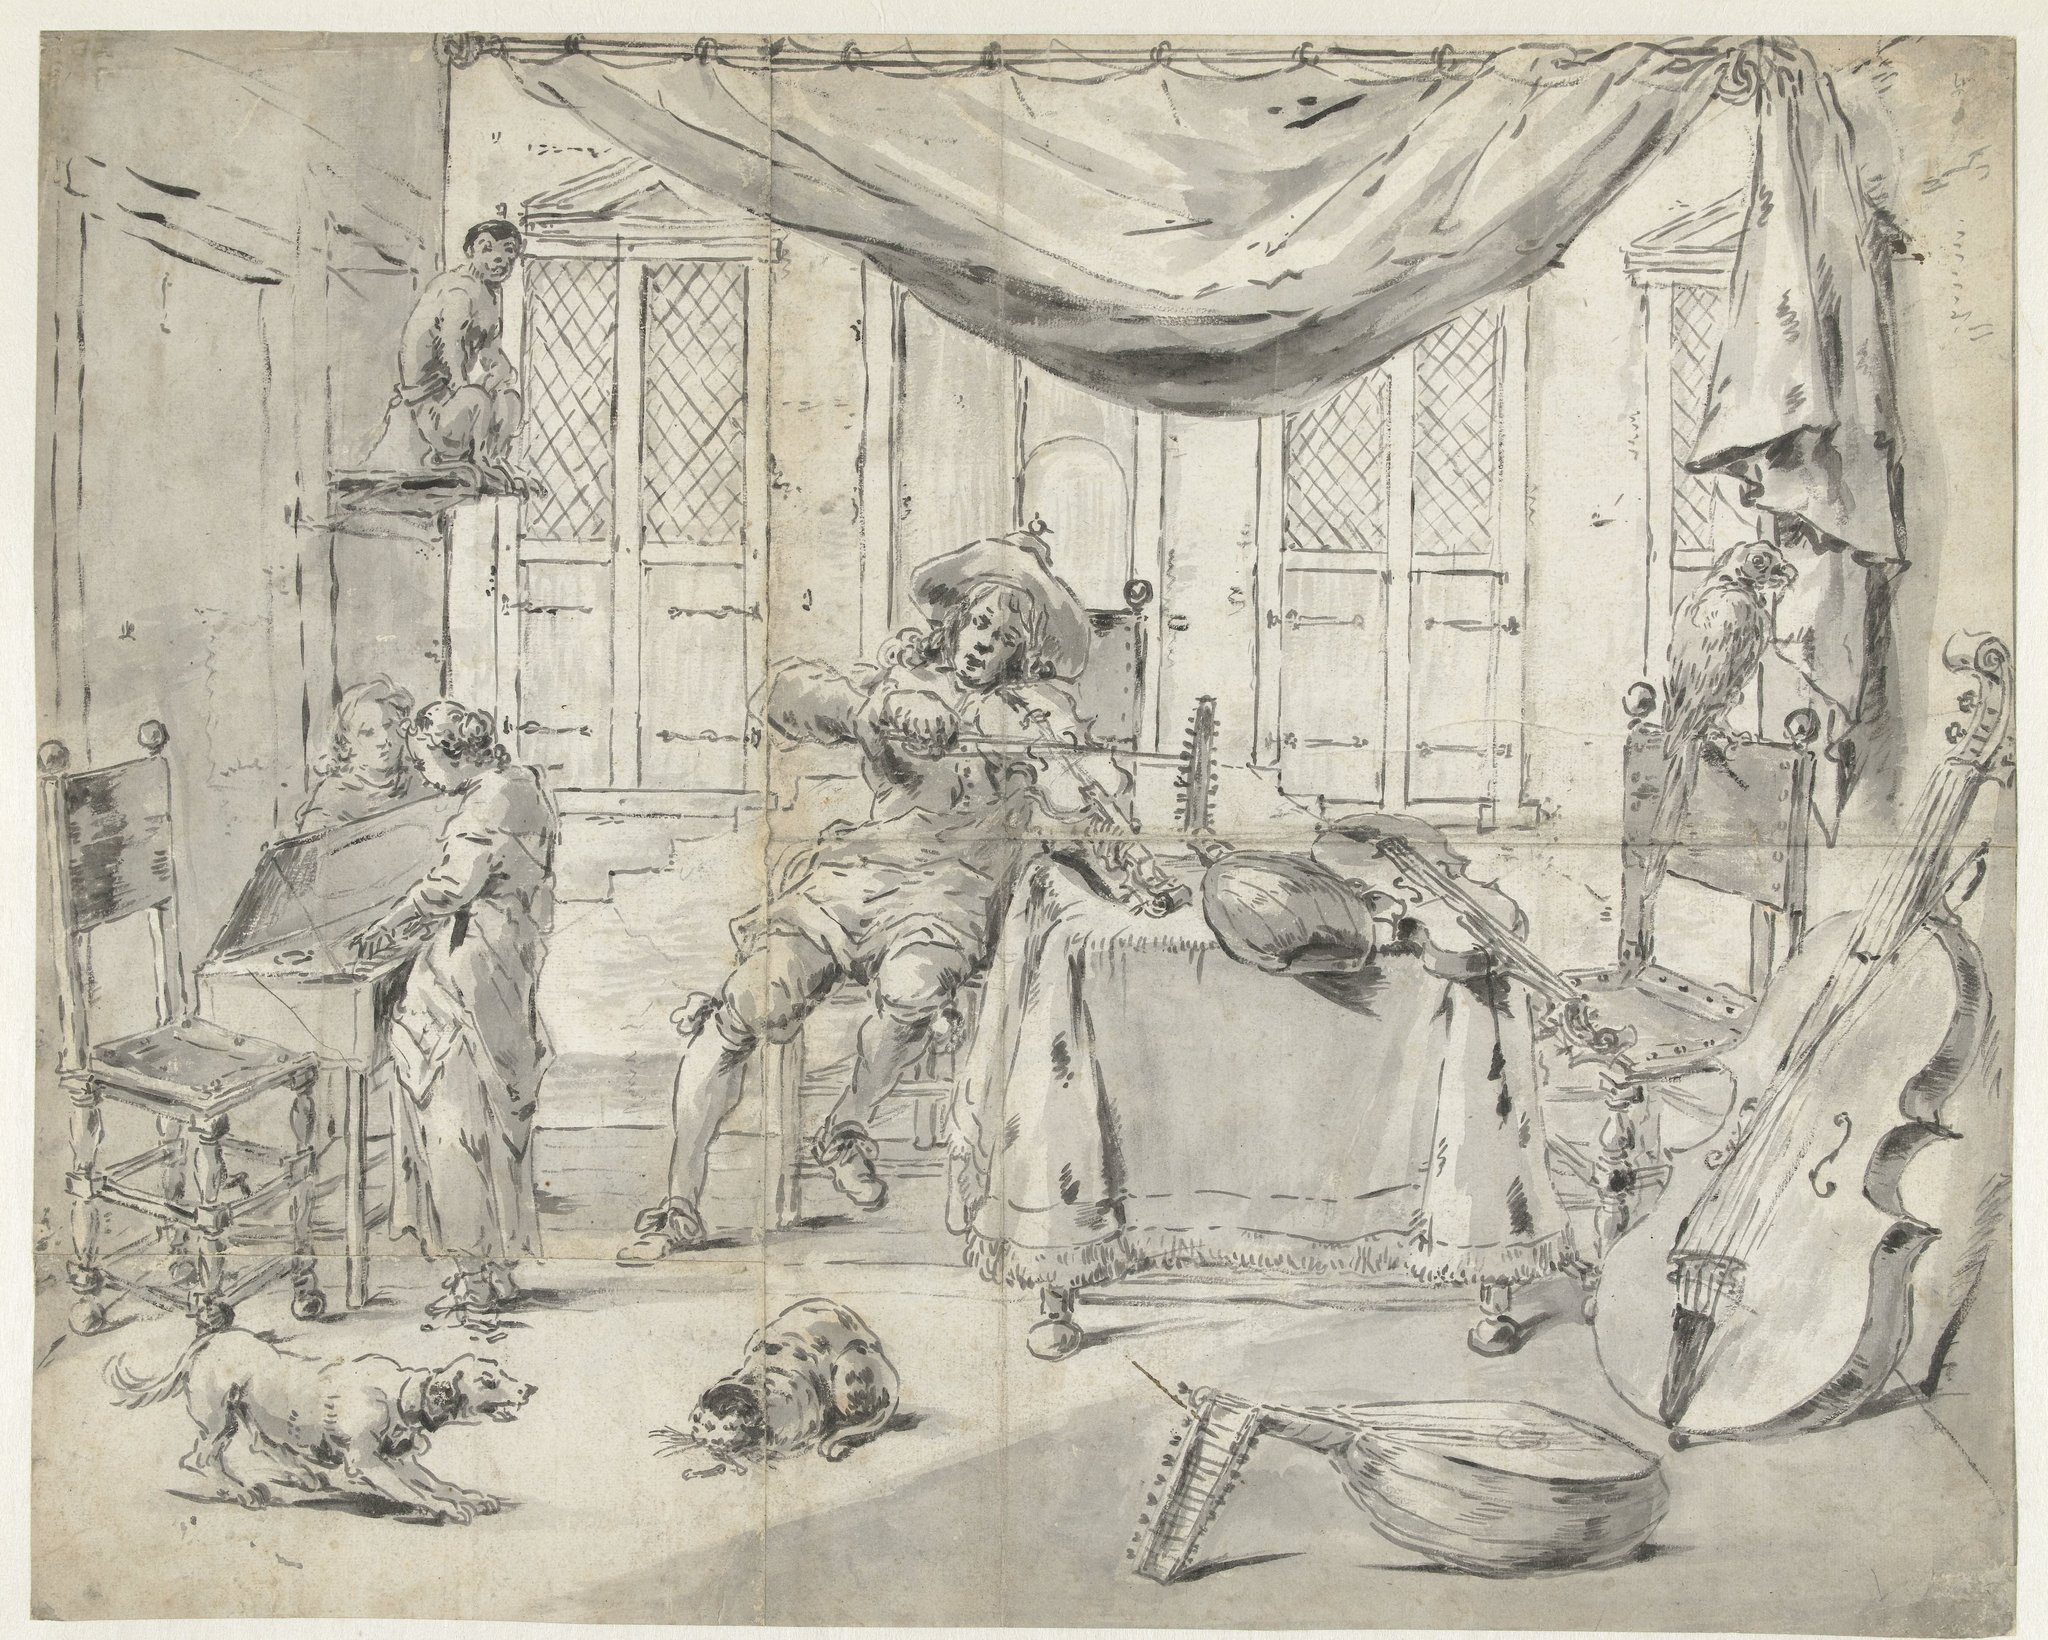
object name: drawing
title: Musicians in an Interior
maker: leonaert bramer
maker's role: draughtsman, painter, print maker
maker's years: 1596-1674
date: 1606-1674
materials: paper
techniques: brush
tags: one person playing keyboard instrument, small group of musicians, chamber orchestra, jazz band, cat, monkeys, apes, spinet, virginal, one person playing string instrument (bowed), ornamental birds: parrot, interior of the house, string instruments (bowed), dog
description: In the 17th century, being able to play several instruments was more important than perfectly mastering a single one. While making music together, one could then switch instruments. This drawing is probably a design for a mural intended for a music room. Unfortunately, we do not know where or if it was executed; almost all of Bramer’s interior paintings have been lost.